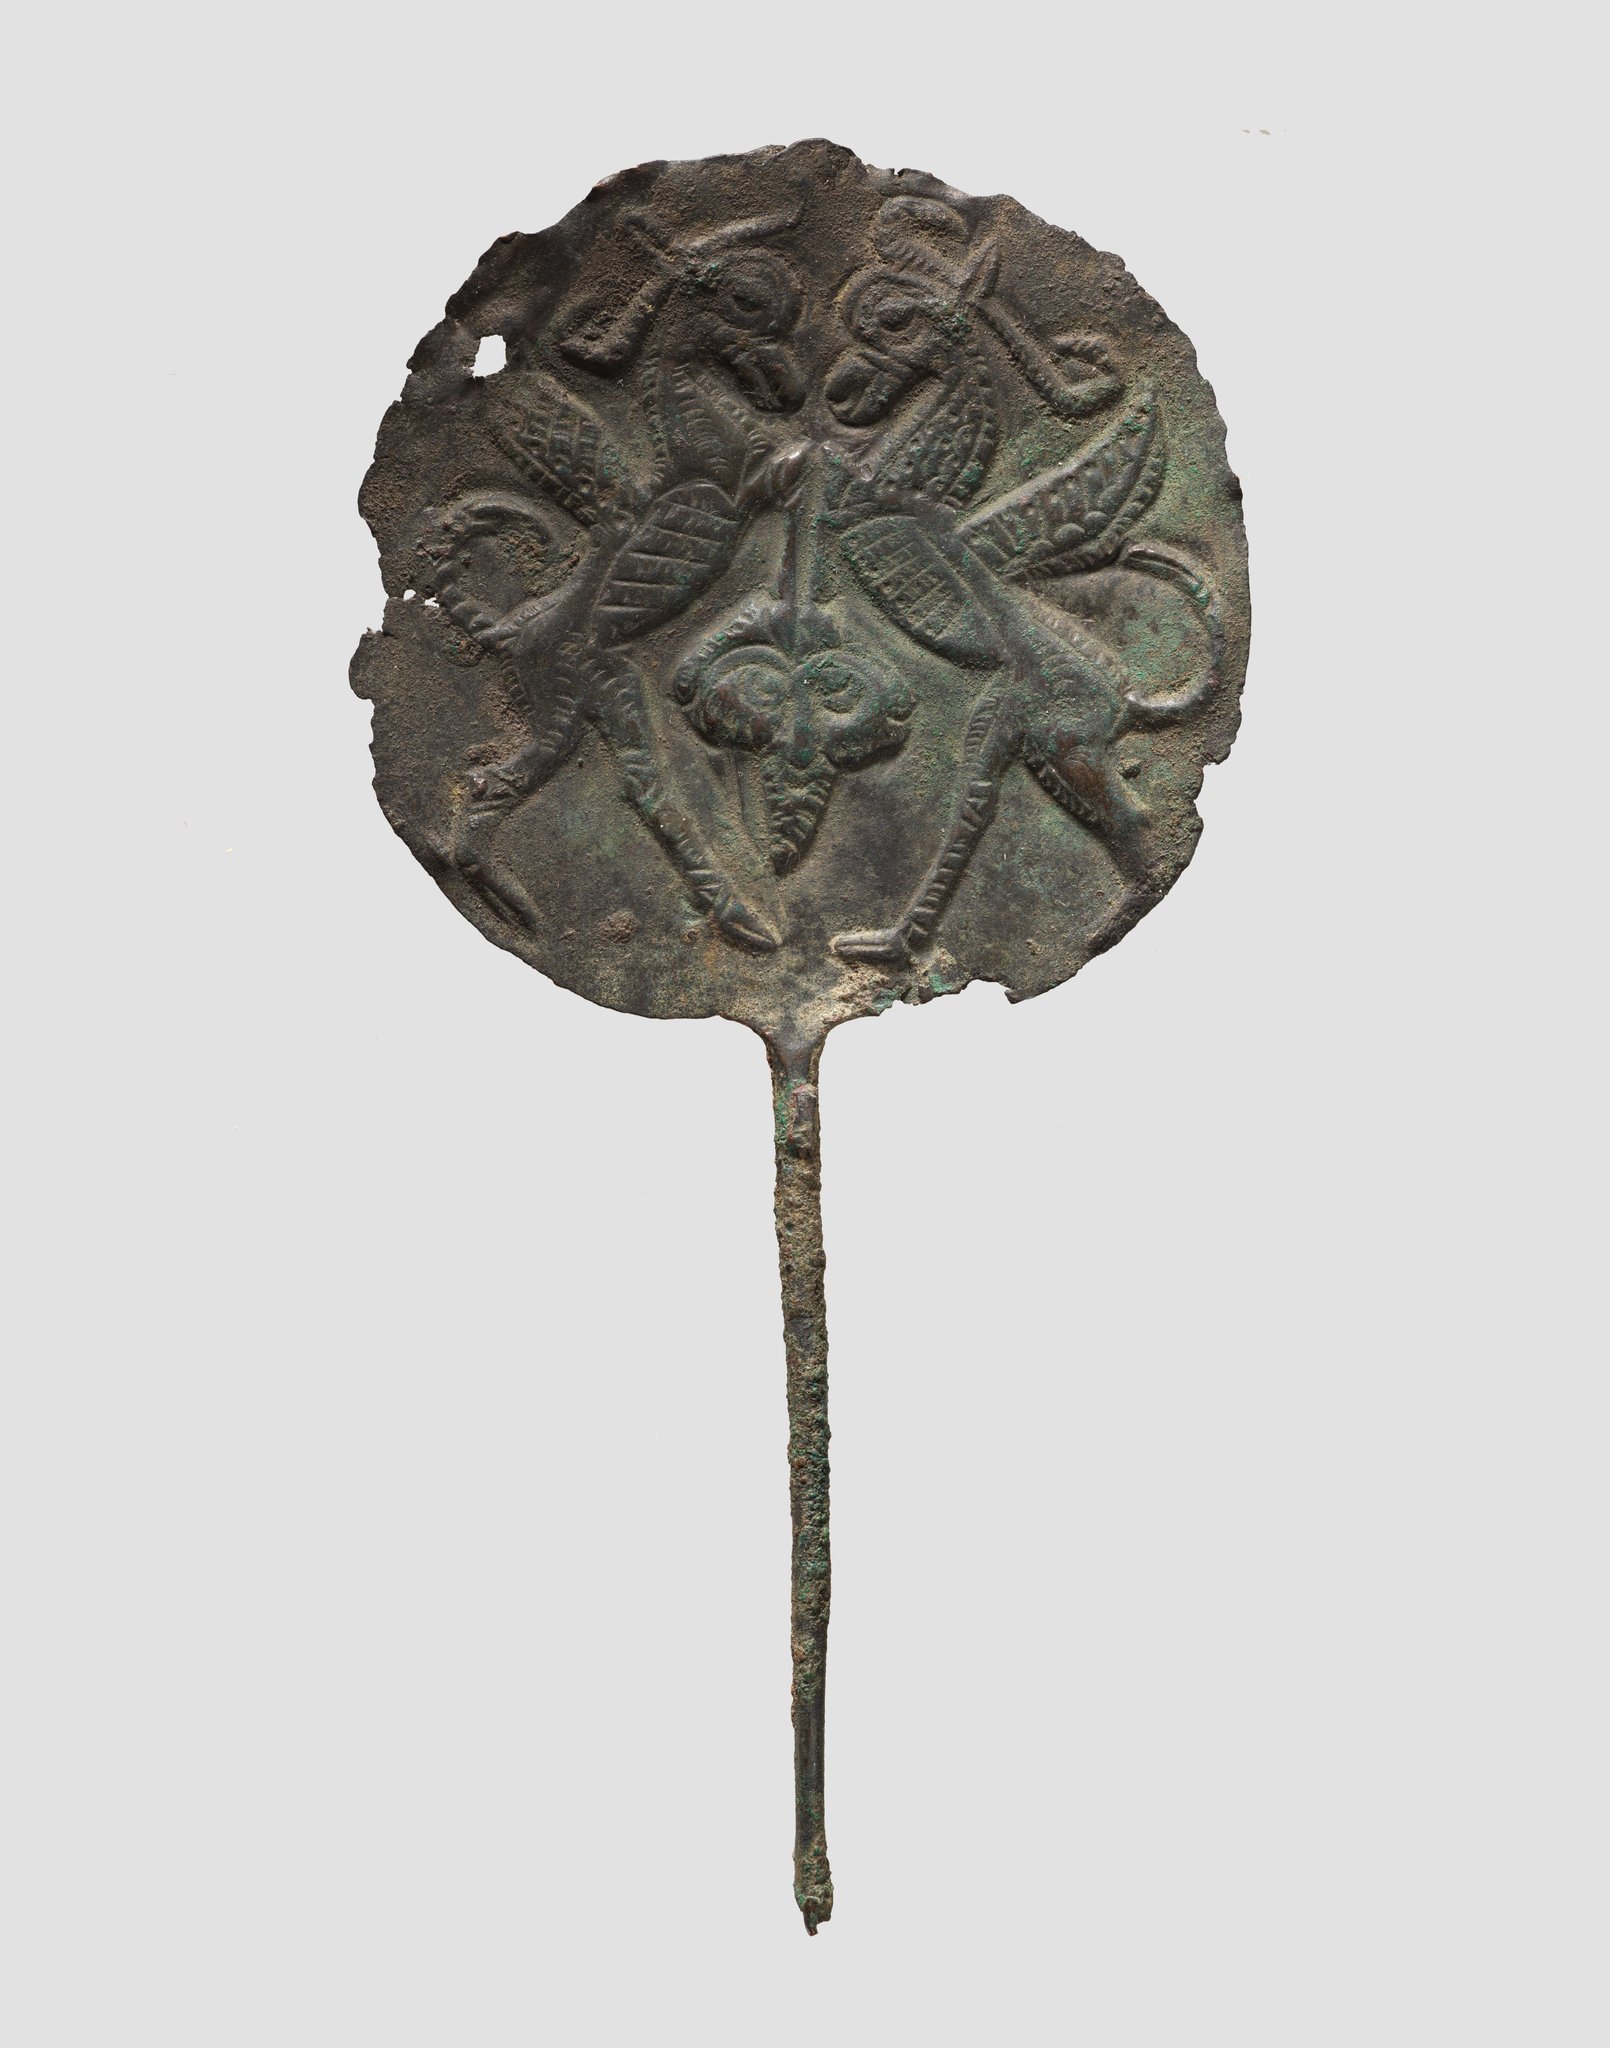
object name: pin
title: Disc-headed pin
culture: iranian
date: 800-601 BCE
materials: bronze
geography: iran, luristan